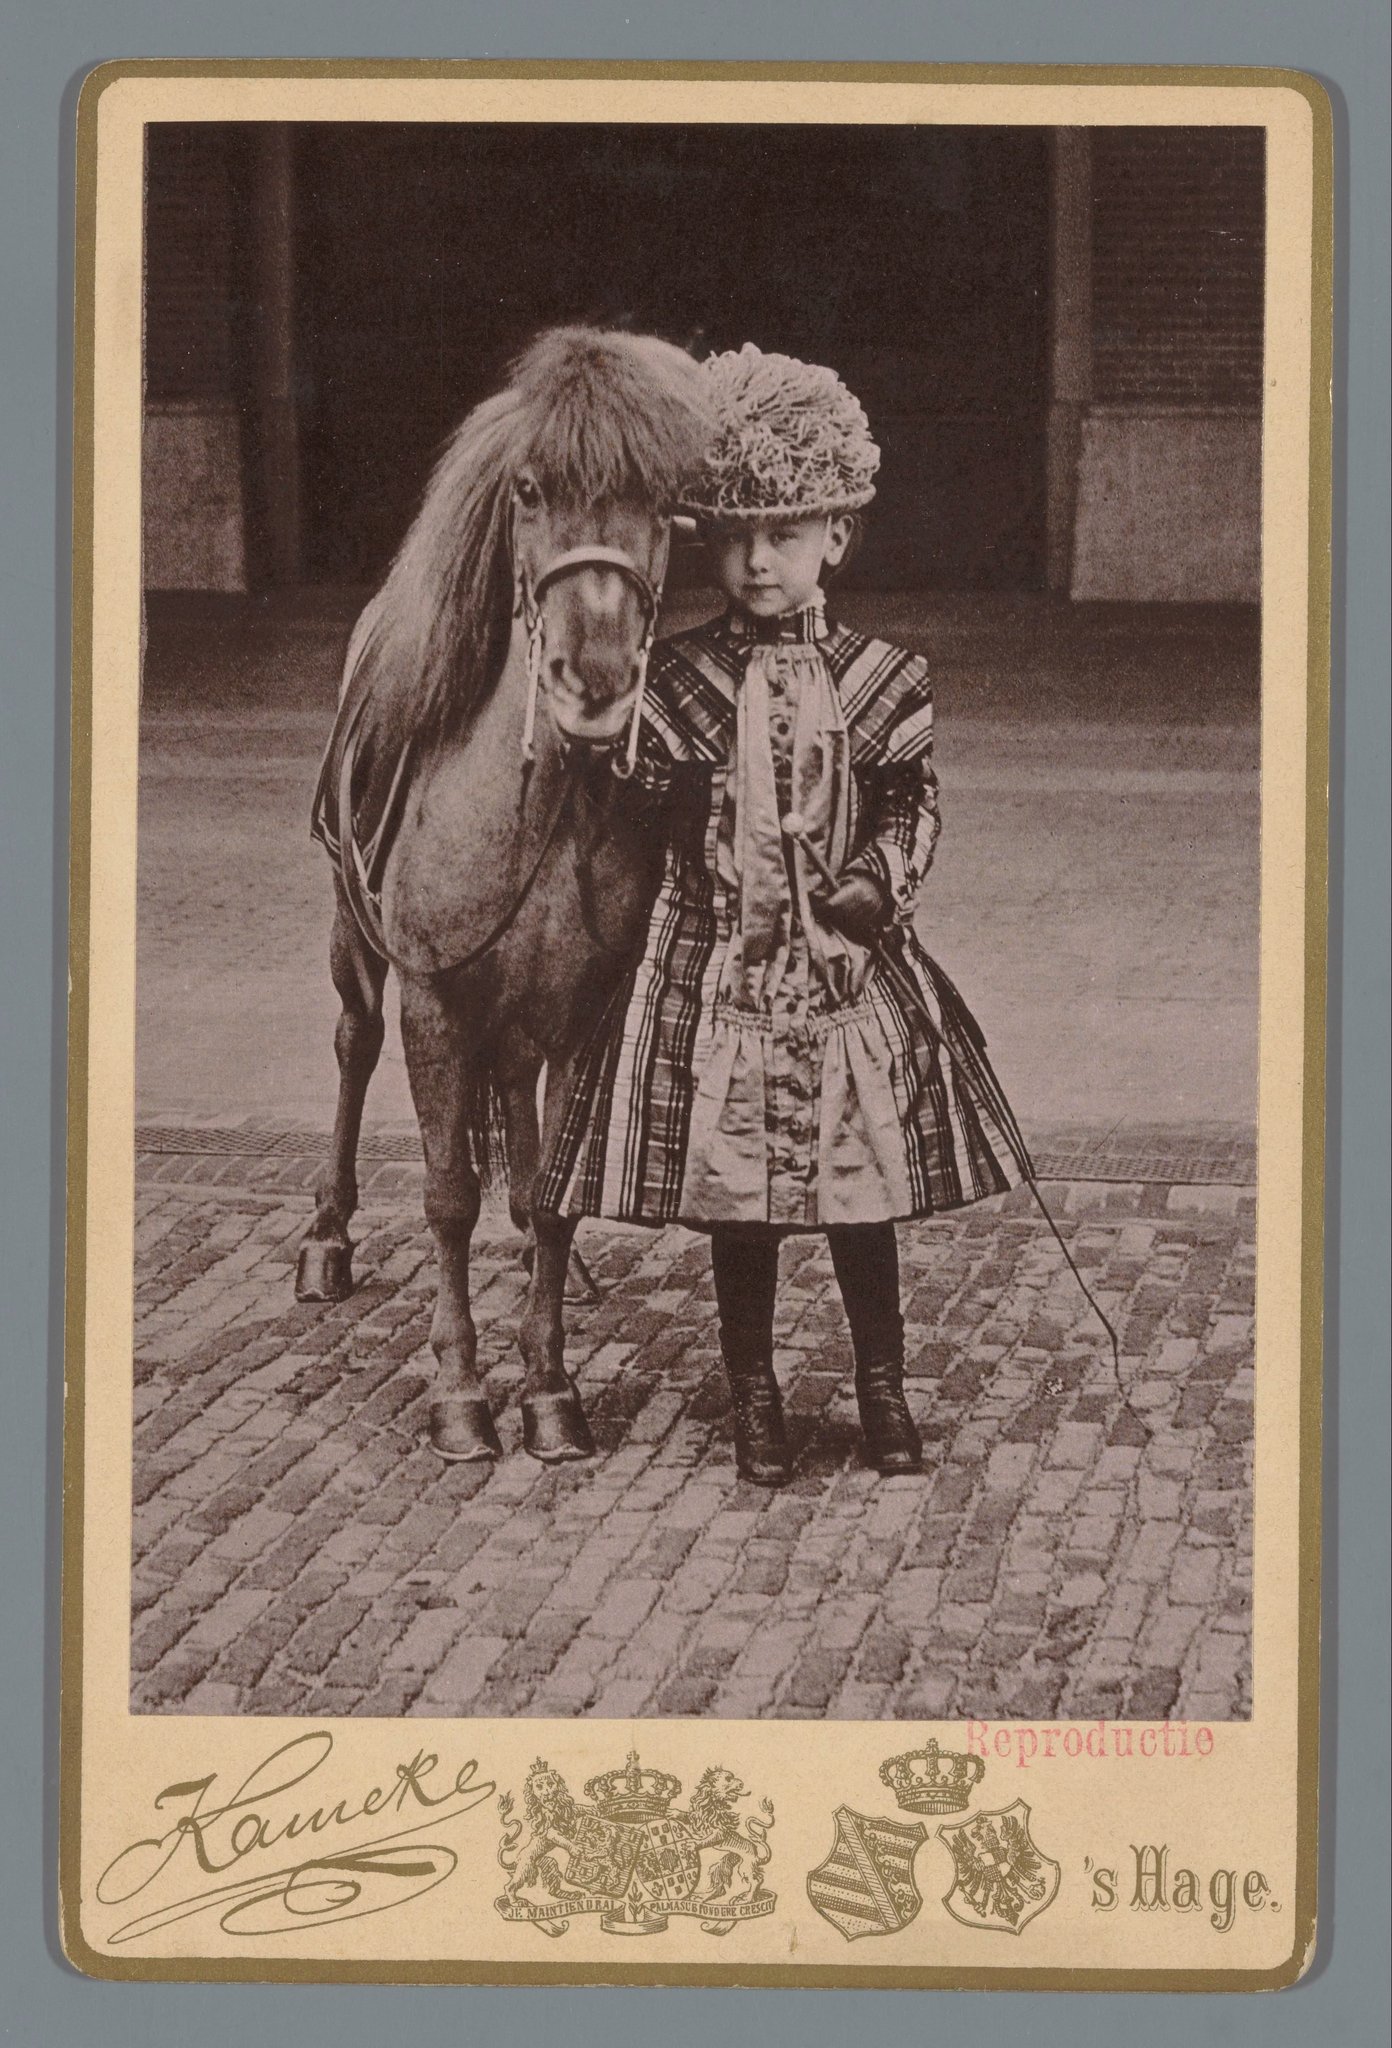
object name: cabinet photograph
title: Portret van prinses Wilhelmina met haar pony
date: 1888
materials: cardboard, paper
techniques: photograph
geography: the hague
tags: the hague, print maker, wilhelmina of the netherlands, crown princess, historical persons, horse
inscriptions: inscription: ‘Wilhelmina 1888’, stamp: ‘Reproductie’, inscription: ‘Kameke/ PORTRETSCHILDER EN HOFPHOTOGRAPH/ van H.H.M.M. den Koning en de Koningin/ der Nederlanden/ en van H.K.H. Mevrouw de Prinses Albert/ von Saksen Altenburg/ 's GRAVENHAGE./ Javastraat No. 20,/ by de Alexanderstraat’, number: ‘50’, stamp: ‘A. FELS/ BOEK-, KUNST-, MUZIEKH./ LEESBIBLIOTHEEK/ BAARN.’